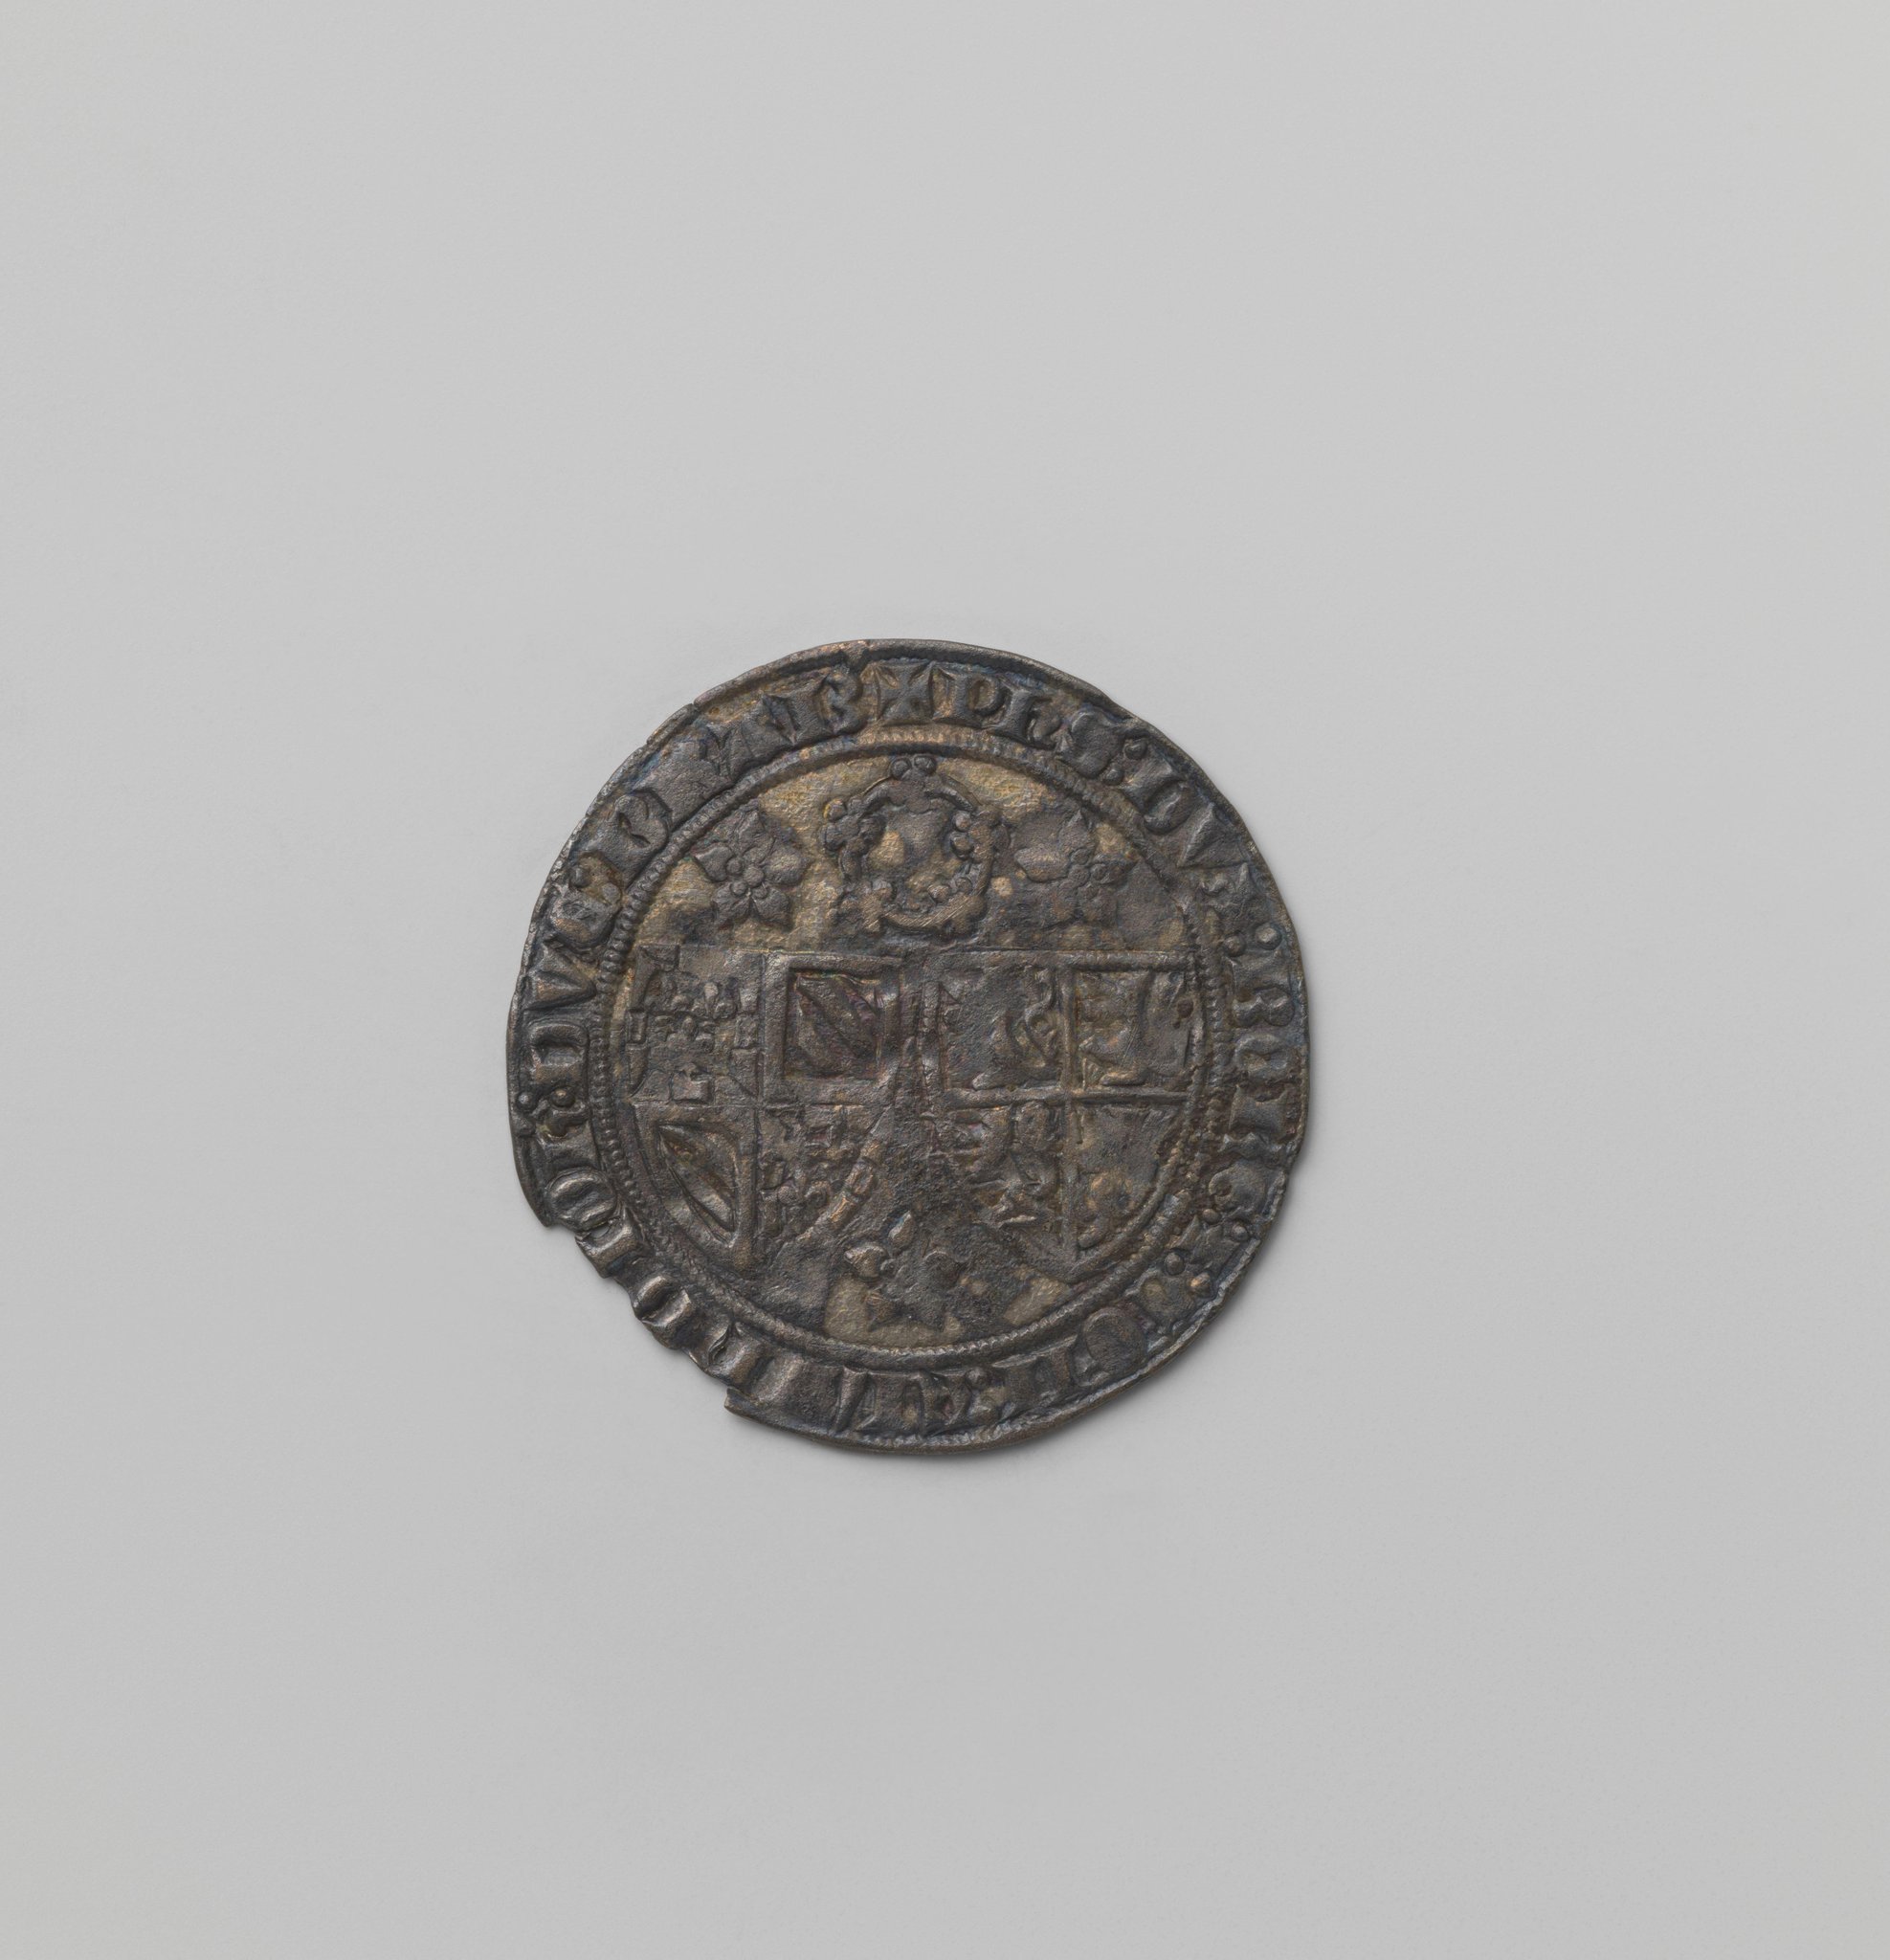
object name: coin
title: Reckheim, Ferdinand van Aspremont-Lynden (1636-1665), duit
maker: heer van reckheim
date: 1636-1665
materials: copper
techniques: striking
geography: rekem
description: Koperen munt. Voorzijde: tussen twee palmtakken gekroond wapenschild van Holland. Keerzijde: binnen een krans drie-regelig opschrift.